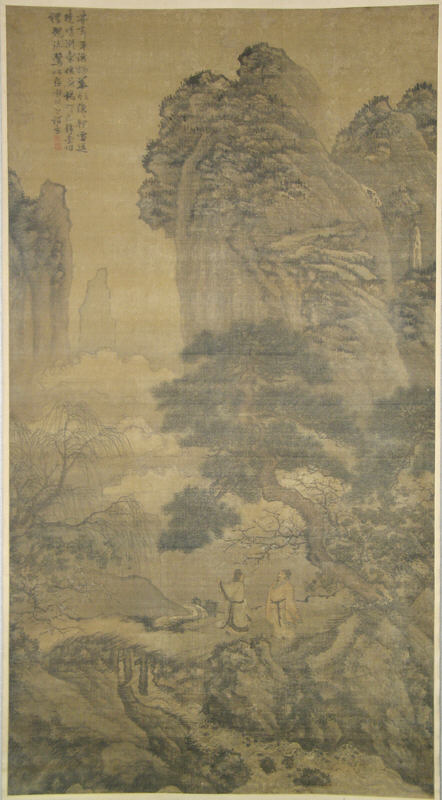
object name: hanging scroll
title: Spring Morning in the Mountains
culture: chinese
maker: xie shichen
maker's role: artist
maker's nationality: chinese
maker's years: 1487-1567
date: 1487-1567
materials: ink, silk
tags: men,mountains,landscapes